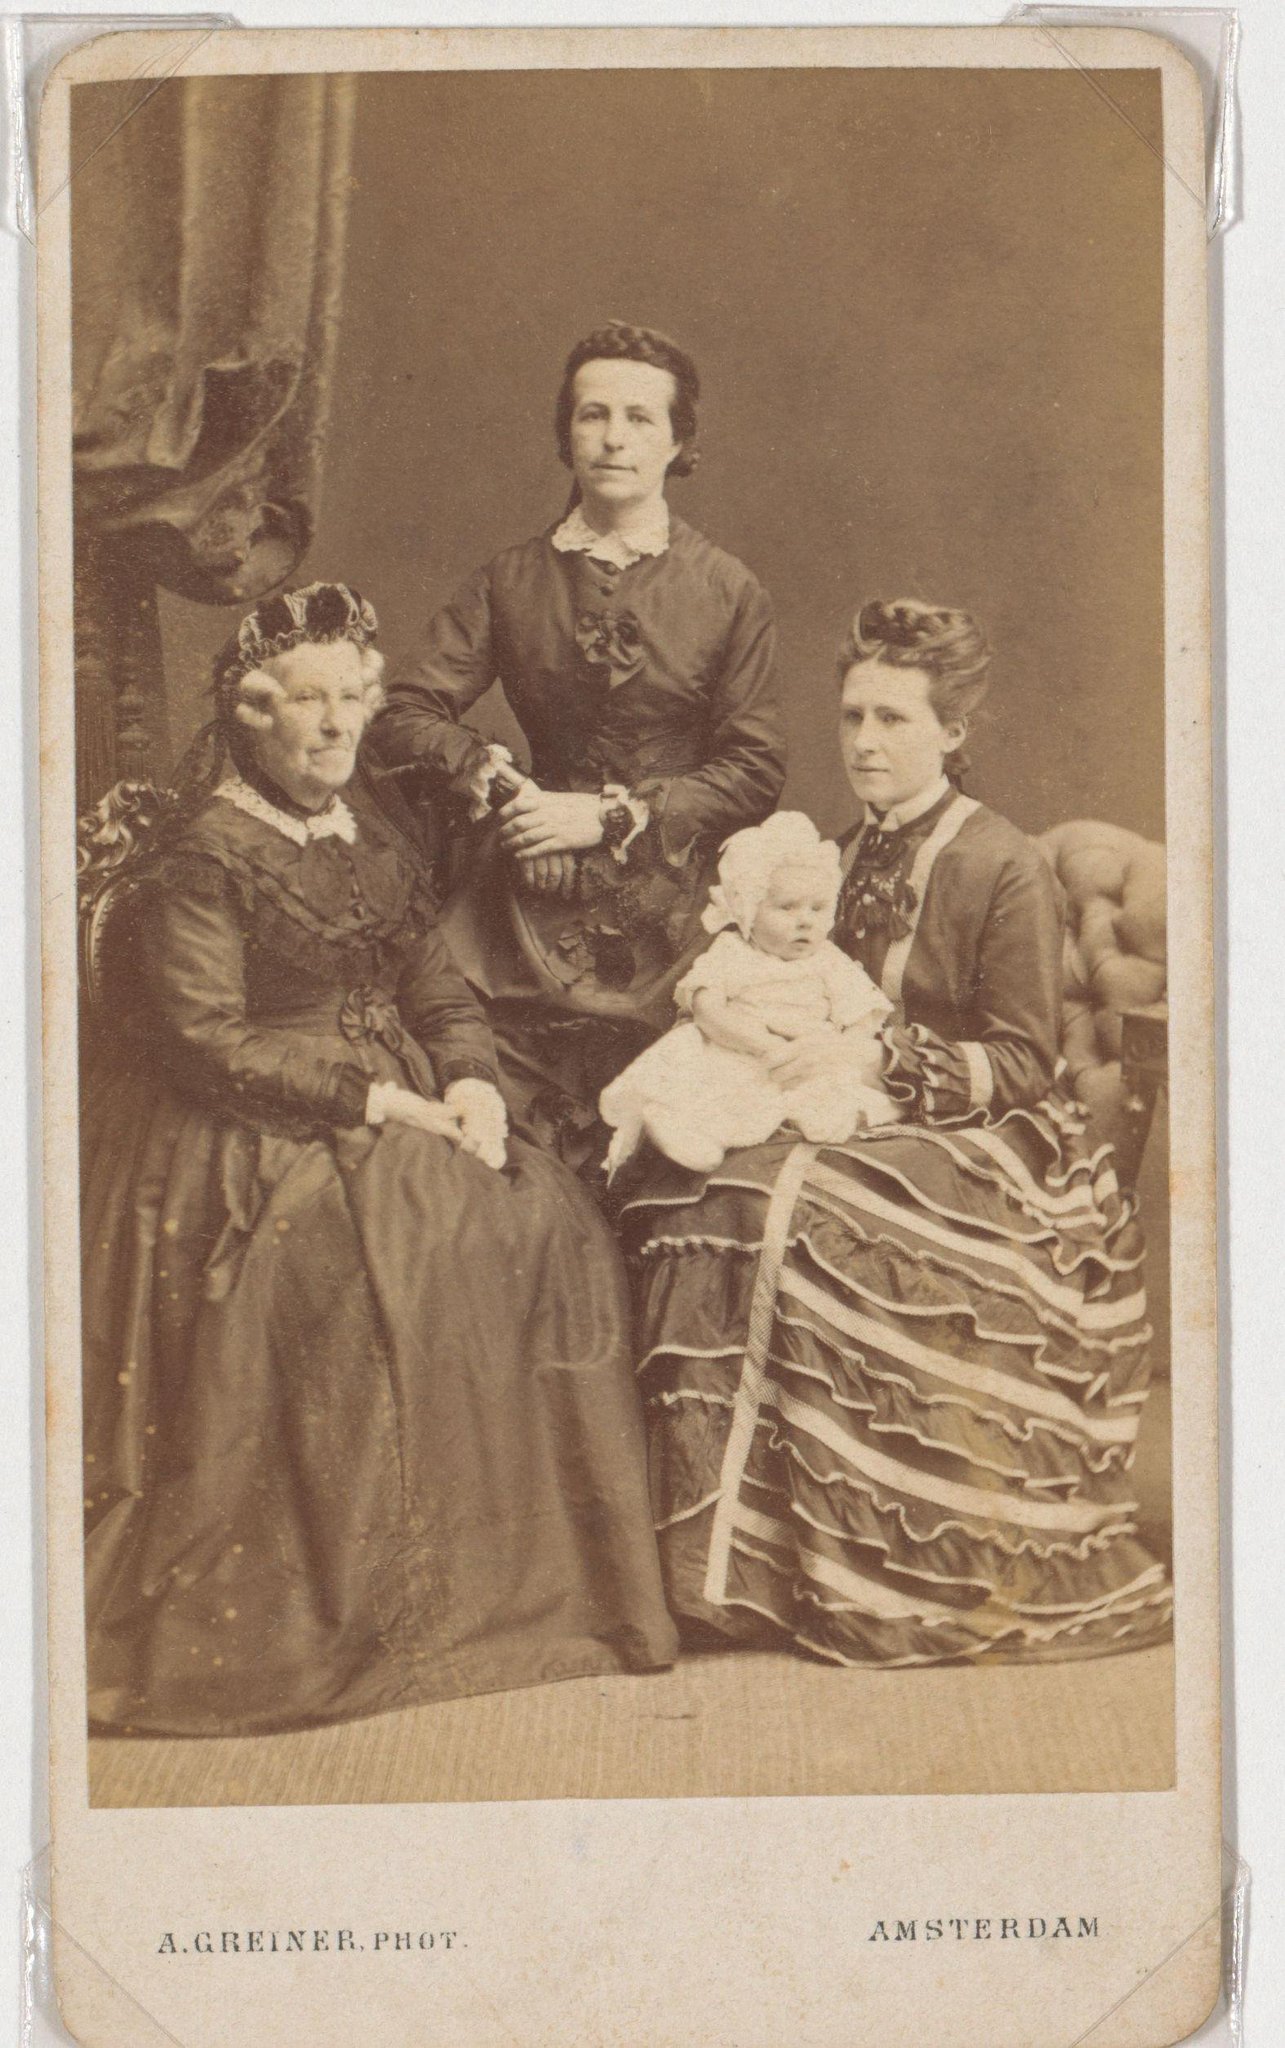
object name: carte de visite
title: Portret van drie vrouwen en een baby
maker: albert greiner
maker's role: fotograaf, fotostudio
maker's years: 1833-1890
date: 1861-1874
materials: cardboard, paper, photographic support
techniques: albumen print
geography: amsterdam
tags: studio requisites ~ photographer, family group, especially parents with their child(ren), historical persons, amsterdam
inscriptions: negative number: ‘No. 18537’, address: ‘Nieuwendijk L.87 Amsterdam’, inscription: ‘4 geslachten Grm. Egeling-v Vloten, Jane de Vries Robbé, Mimi de Bijl Nachenius, Helena later geh. prof. Sissingh’, inscription: ‘de Bijl Nachenius’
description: Op de foto van links naar rechts: Johanna Maria van Vloten-Egeling, Martina Adriana Egeling-De Vries Robbé en Mimi de Vries Robbé-De Bijl Nachenius met Helena de Bijl Nachenius op schoot.